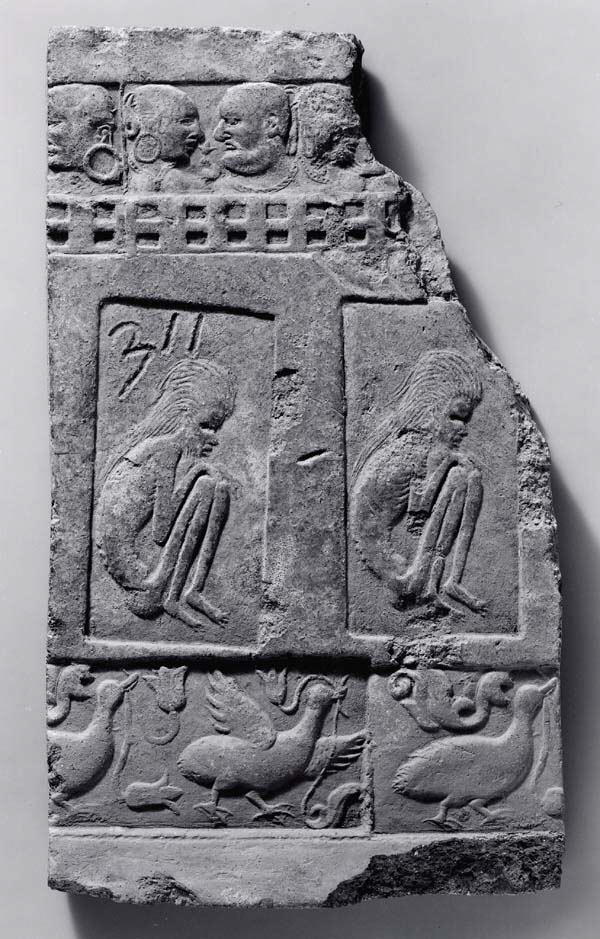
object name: tile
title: Tile with Impressed Figures of Emaciated Ascetics and Couples behind Balconies and Ganders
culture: india, kashmir, harwan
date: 401-600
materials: terracotta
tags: birds,kashmir,couples